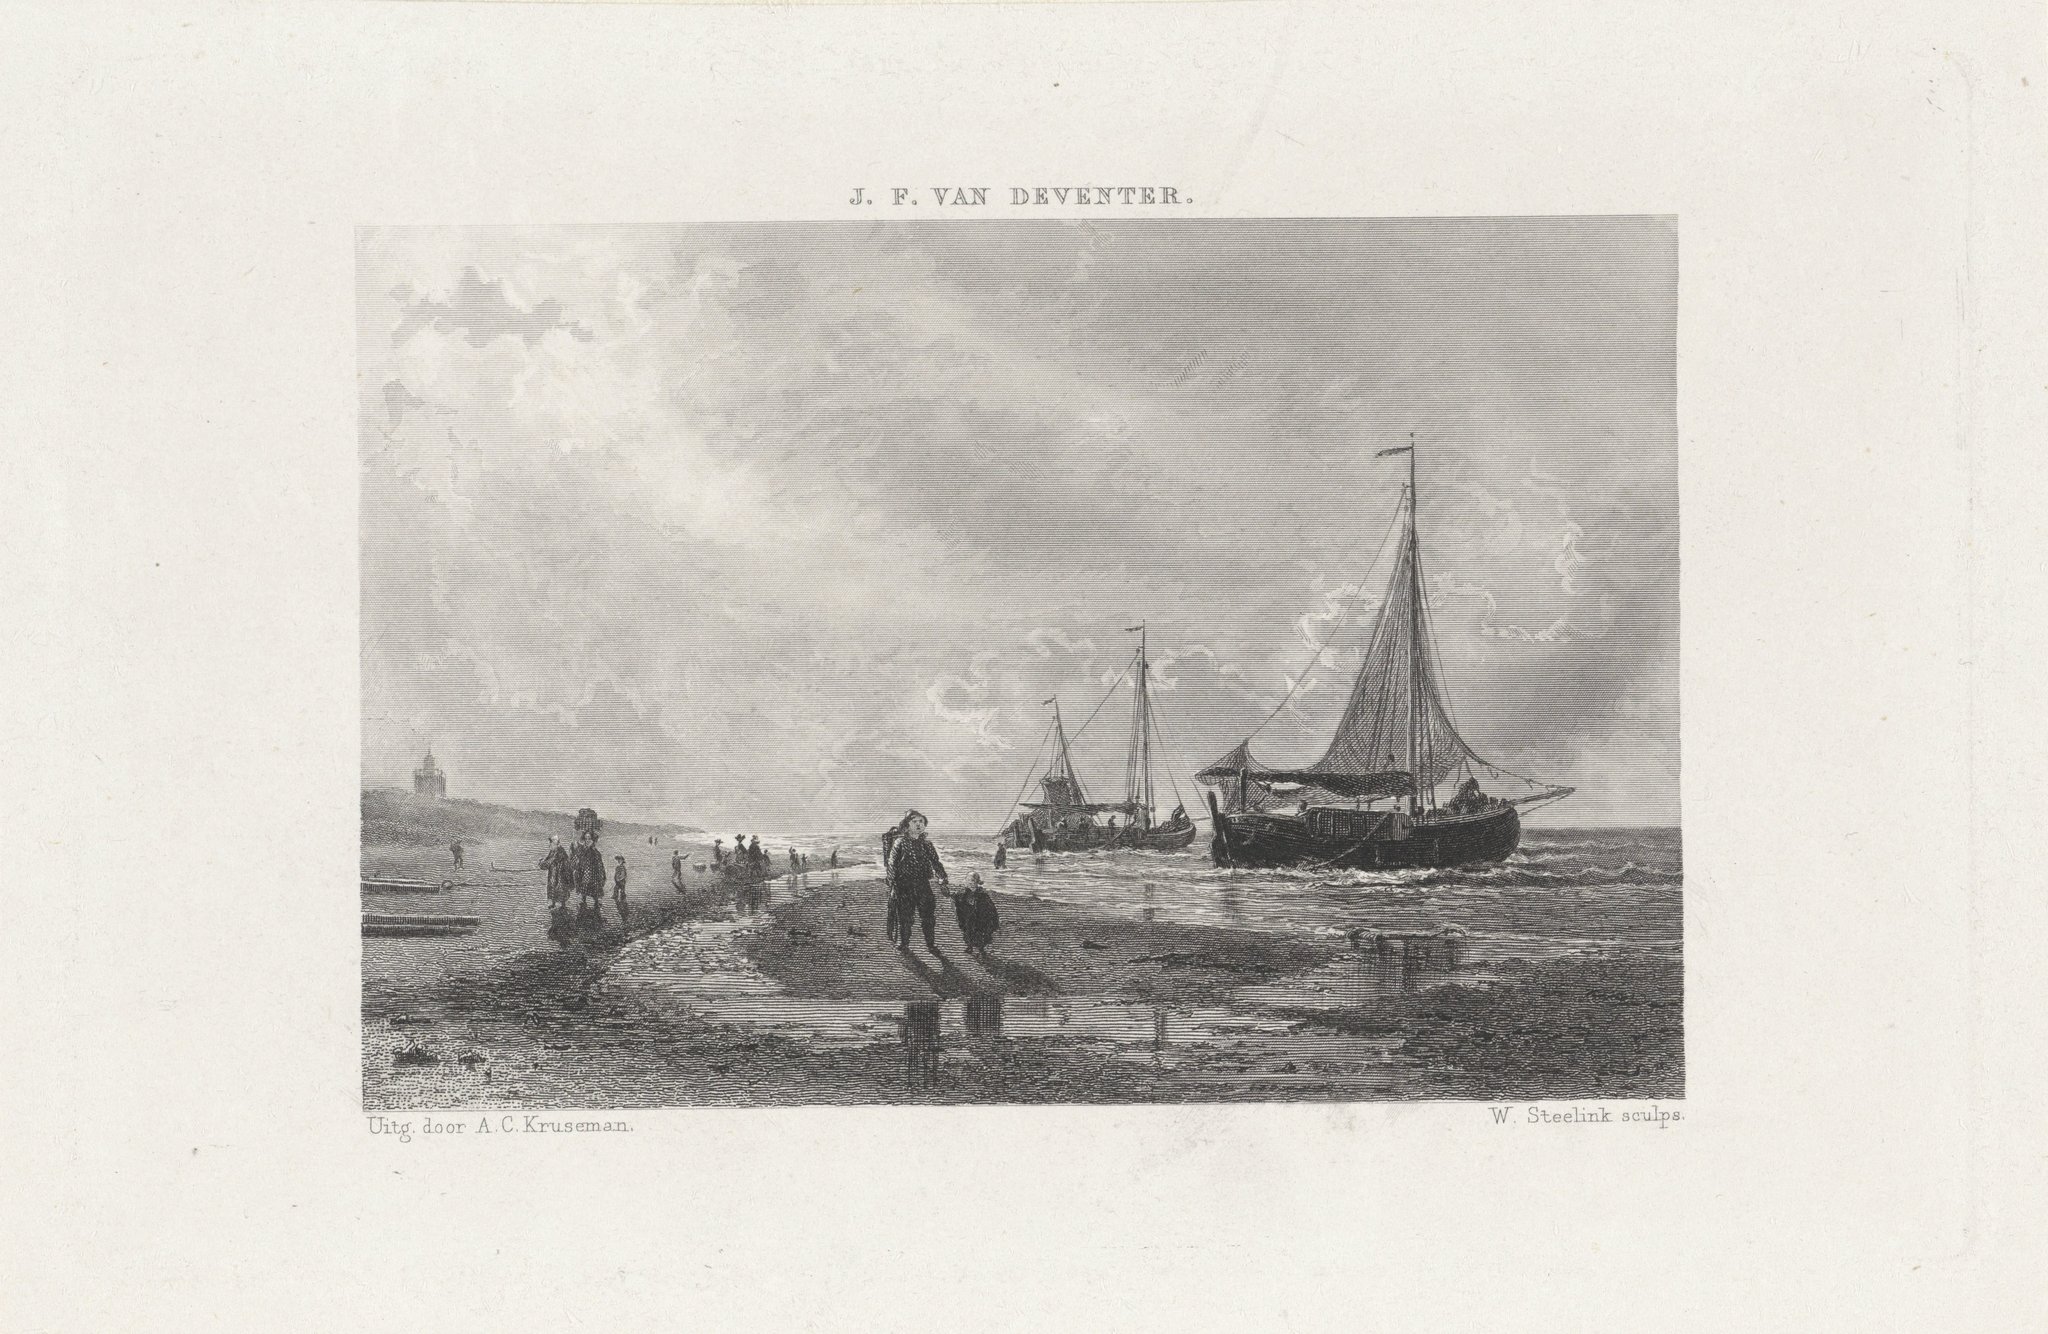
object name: print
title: Boten aan het strand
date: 1865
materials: paper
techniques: etching, engraving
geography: haarlem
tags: sailing-ship, sailing-boat, beach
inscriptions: collector's mark: Lugt 2228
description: Titelpagina voor: Aurora. Jaarboekje voor 1865. Haarlem: Arie Cornelis Kruseman, 1865.